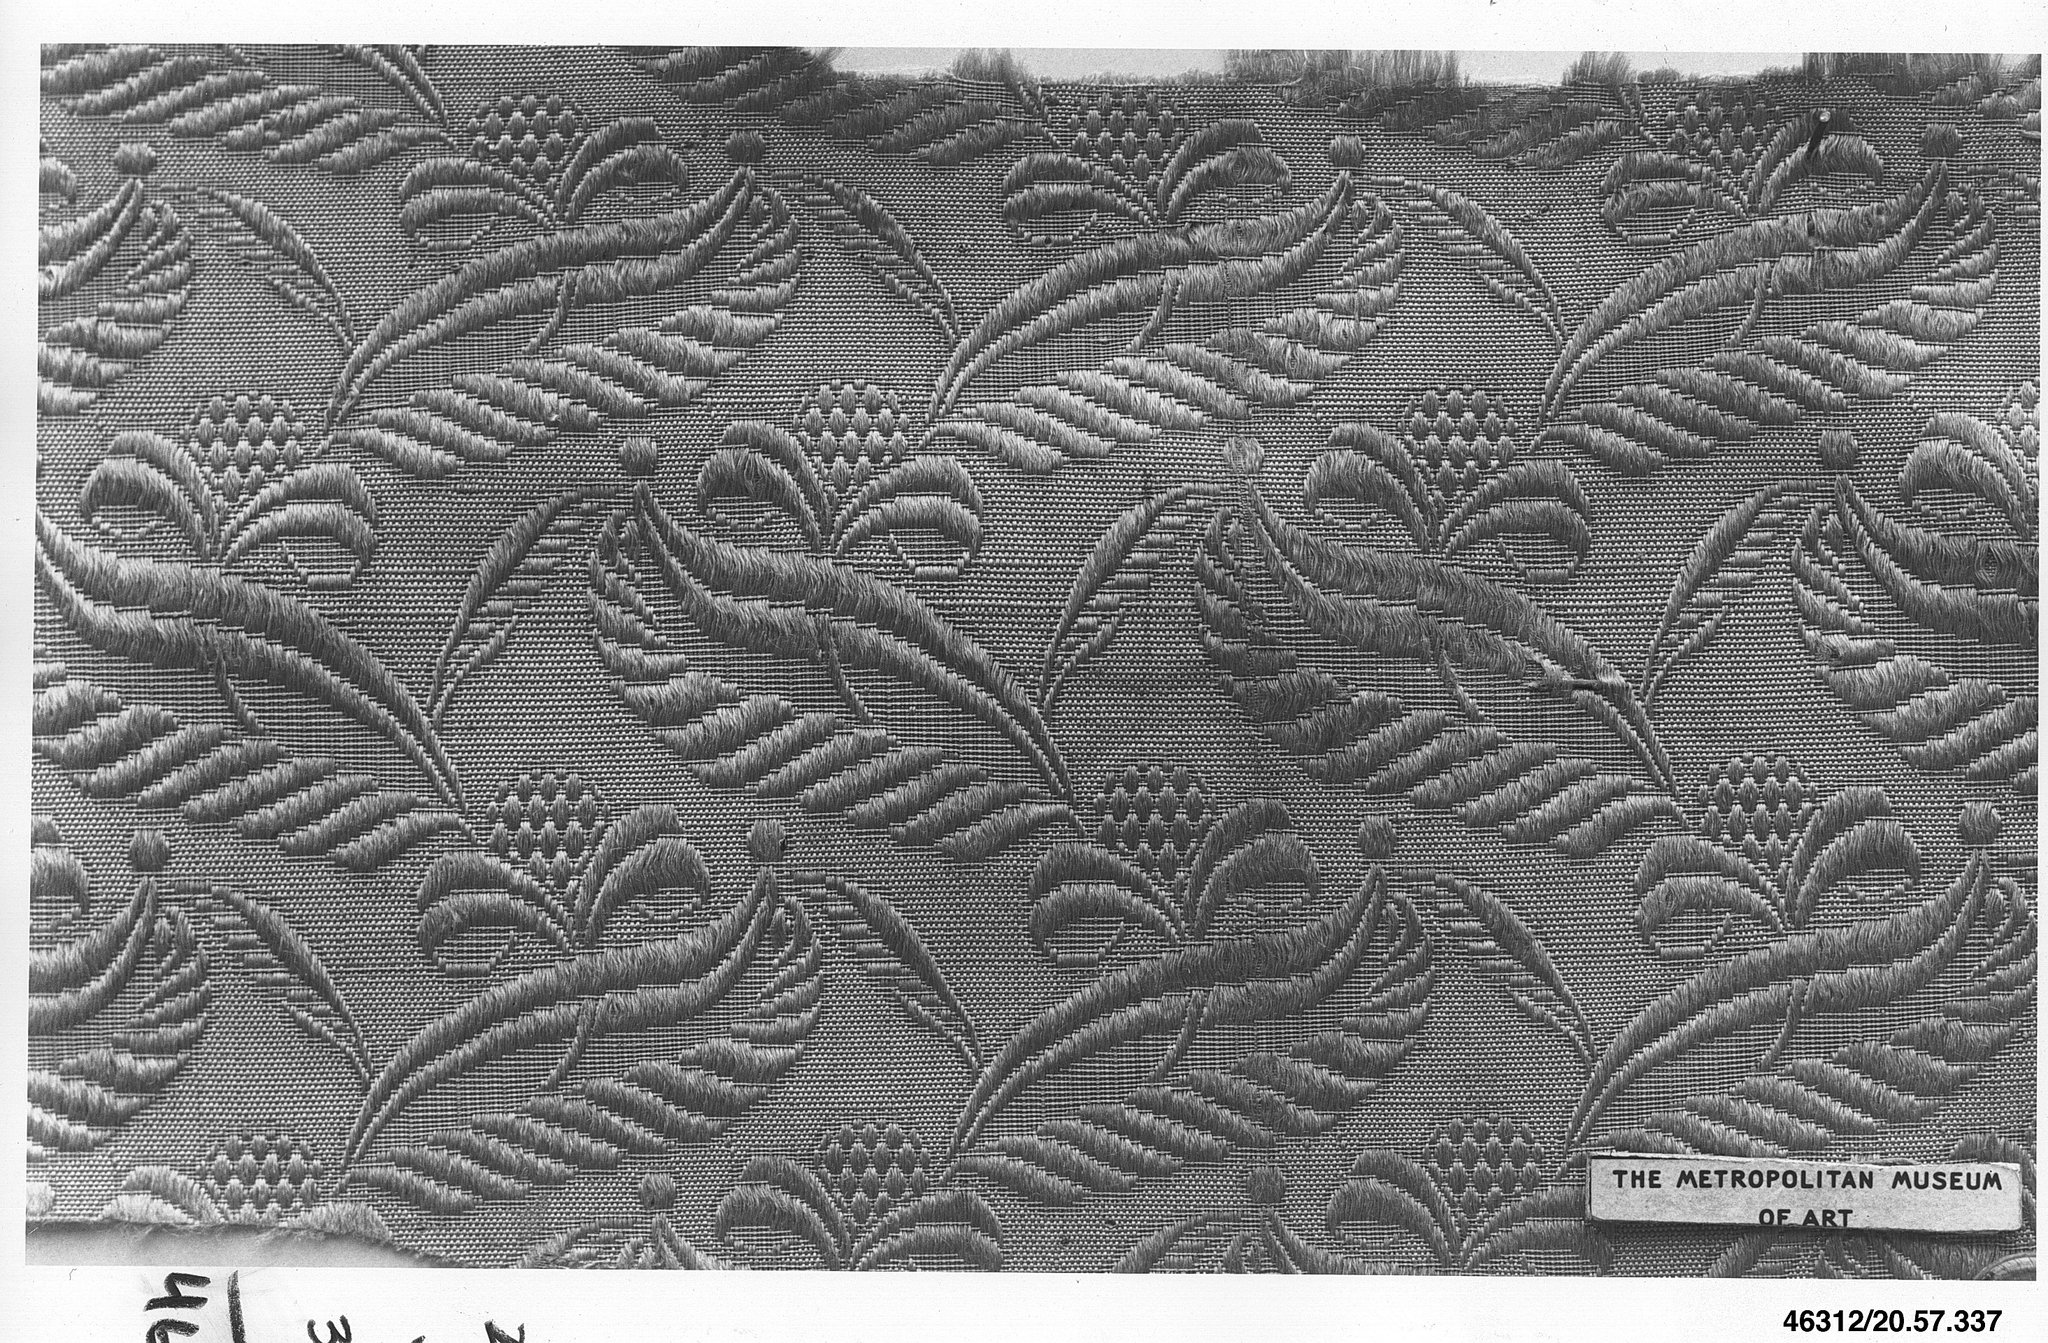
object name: piece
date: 1701-1800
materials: silk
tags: flowers,leaves